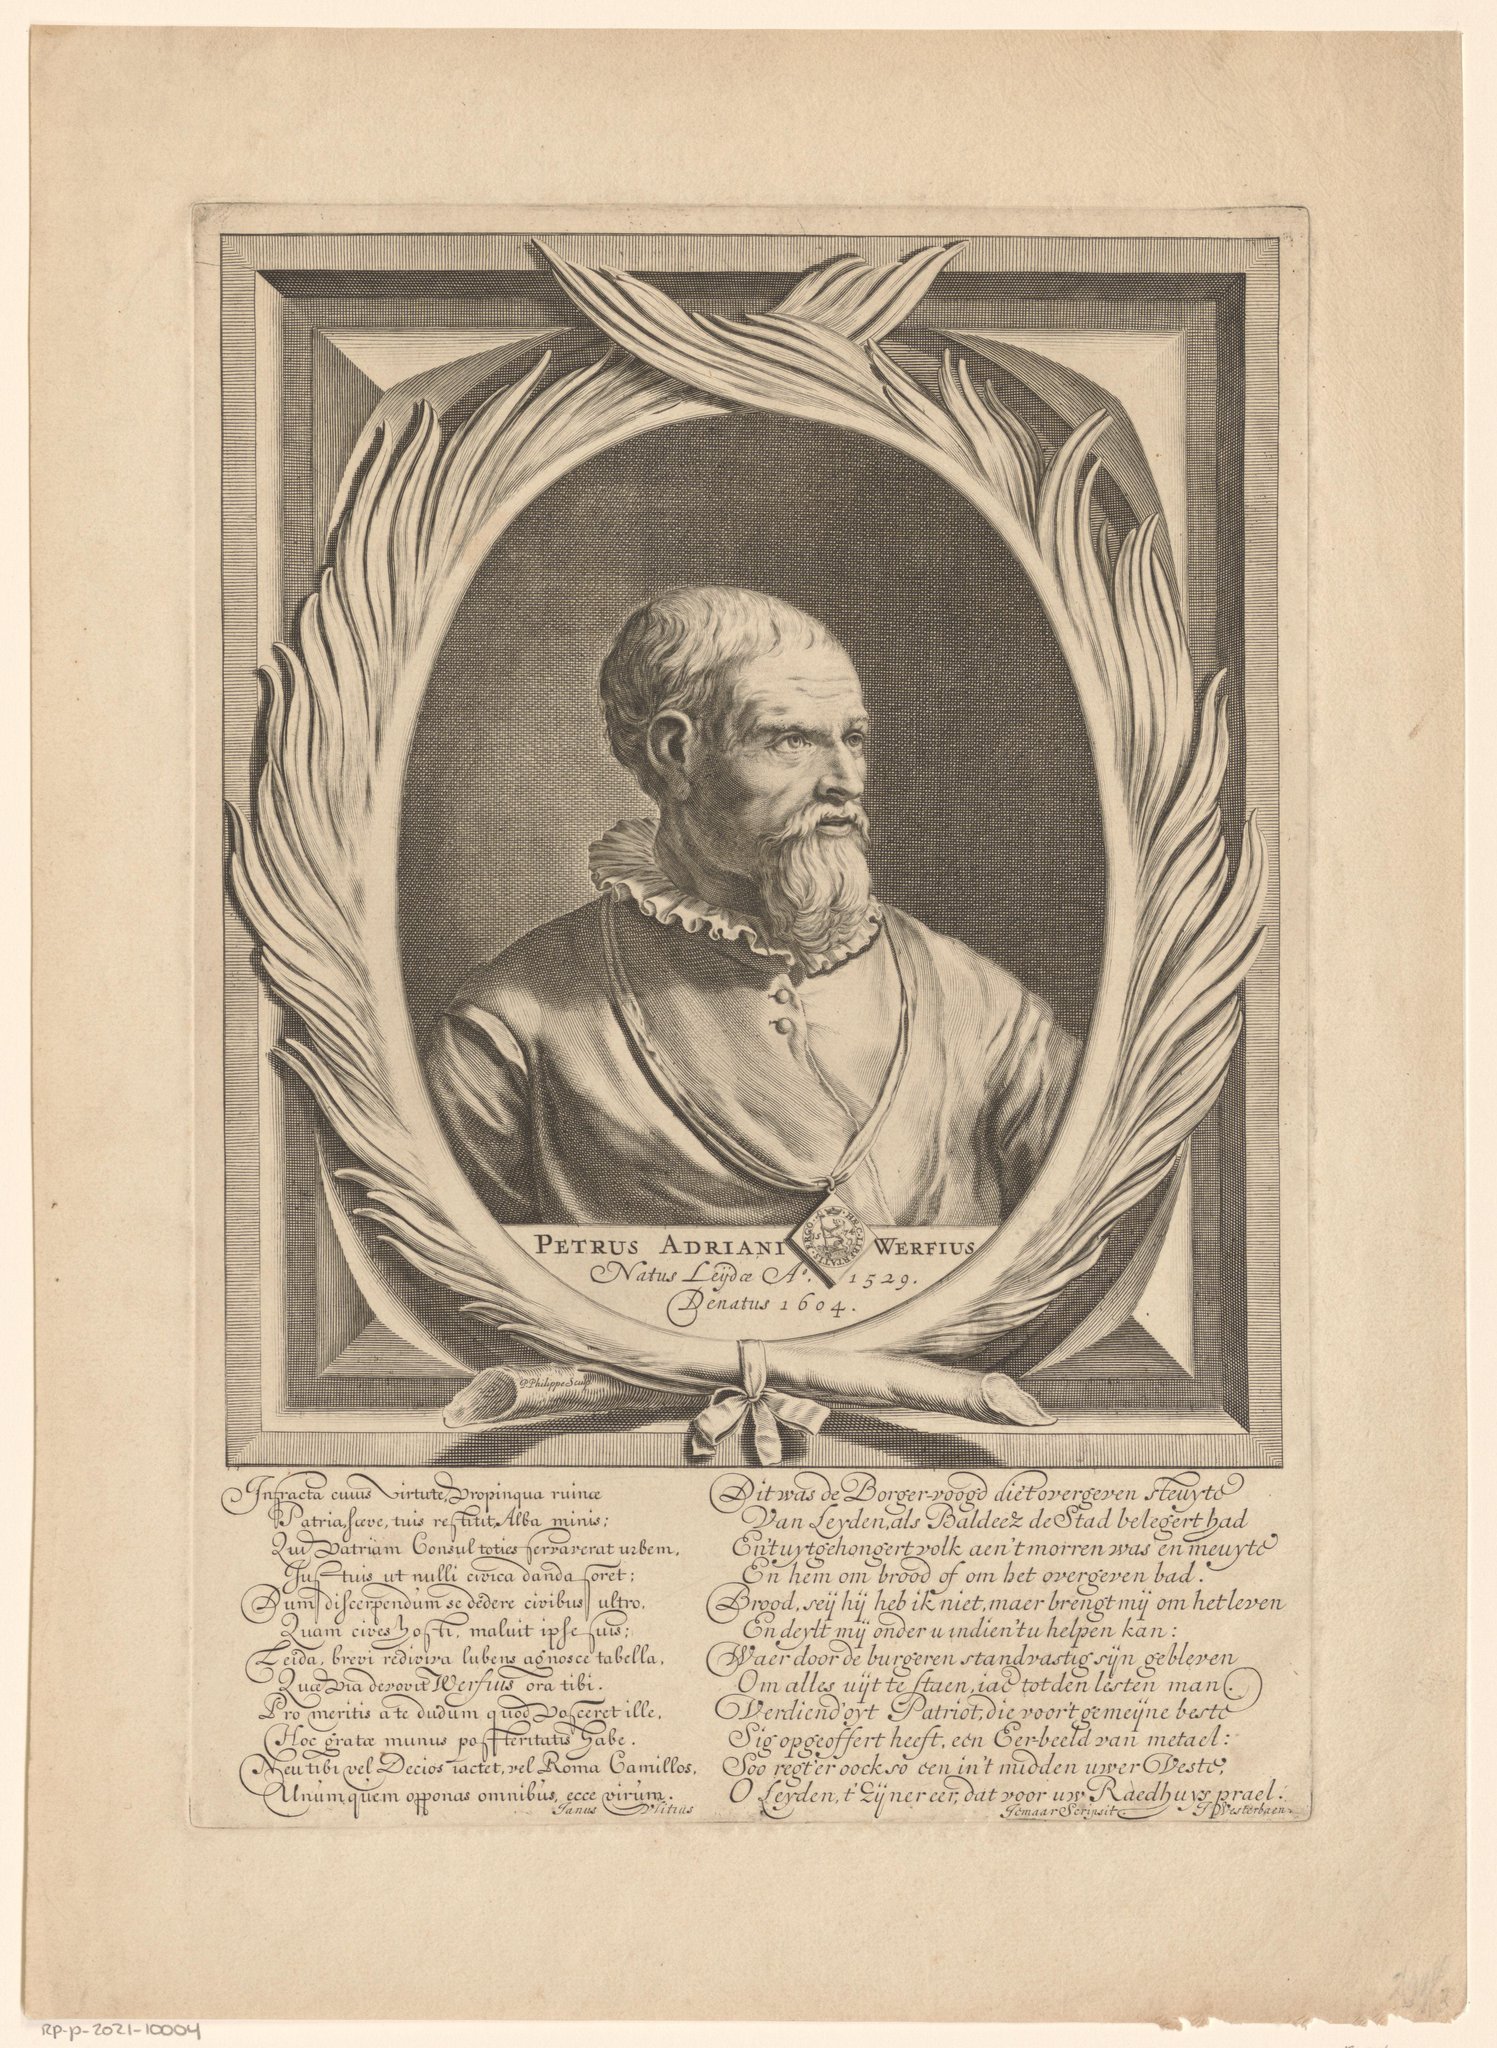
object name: print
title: Portret van Pieter Adriaansz. van der Werff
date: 1645-1702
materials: paper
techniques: engraving, etching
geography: the hague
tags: leiden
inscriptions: collector's mark: Lugt 2228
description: Portret van Pieter Adriaansz. van der Werff, burgemeester van Leiden. Om zijn hals draagt hij een lint met een Leidse noodmunt, uit de tijd van het Spaanse beleg. Onder het portret twee kolommen met elk twaalf regels tekst.